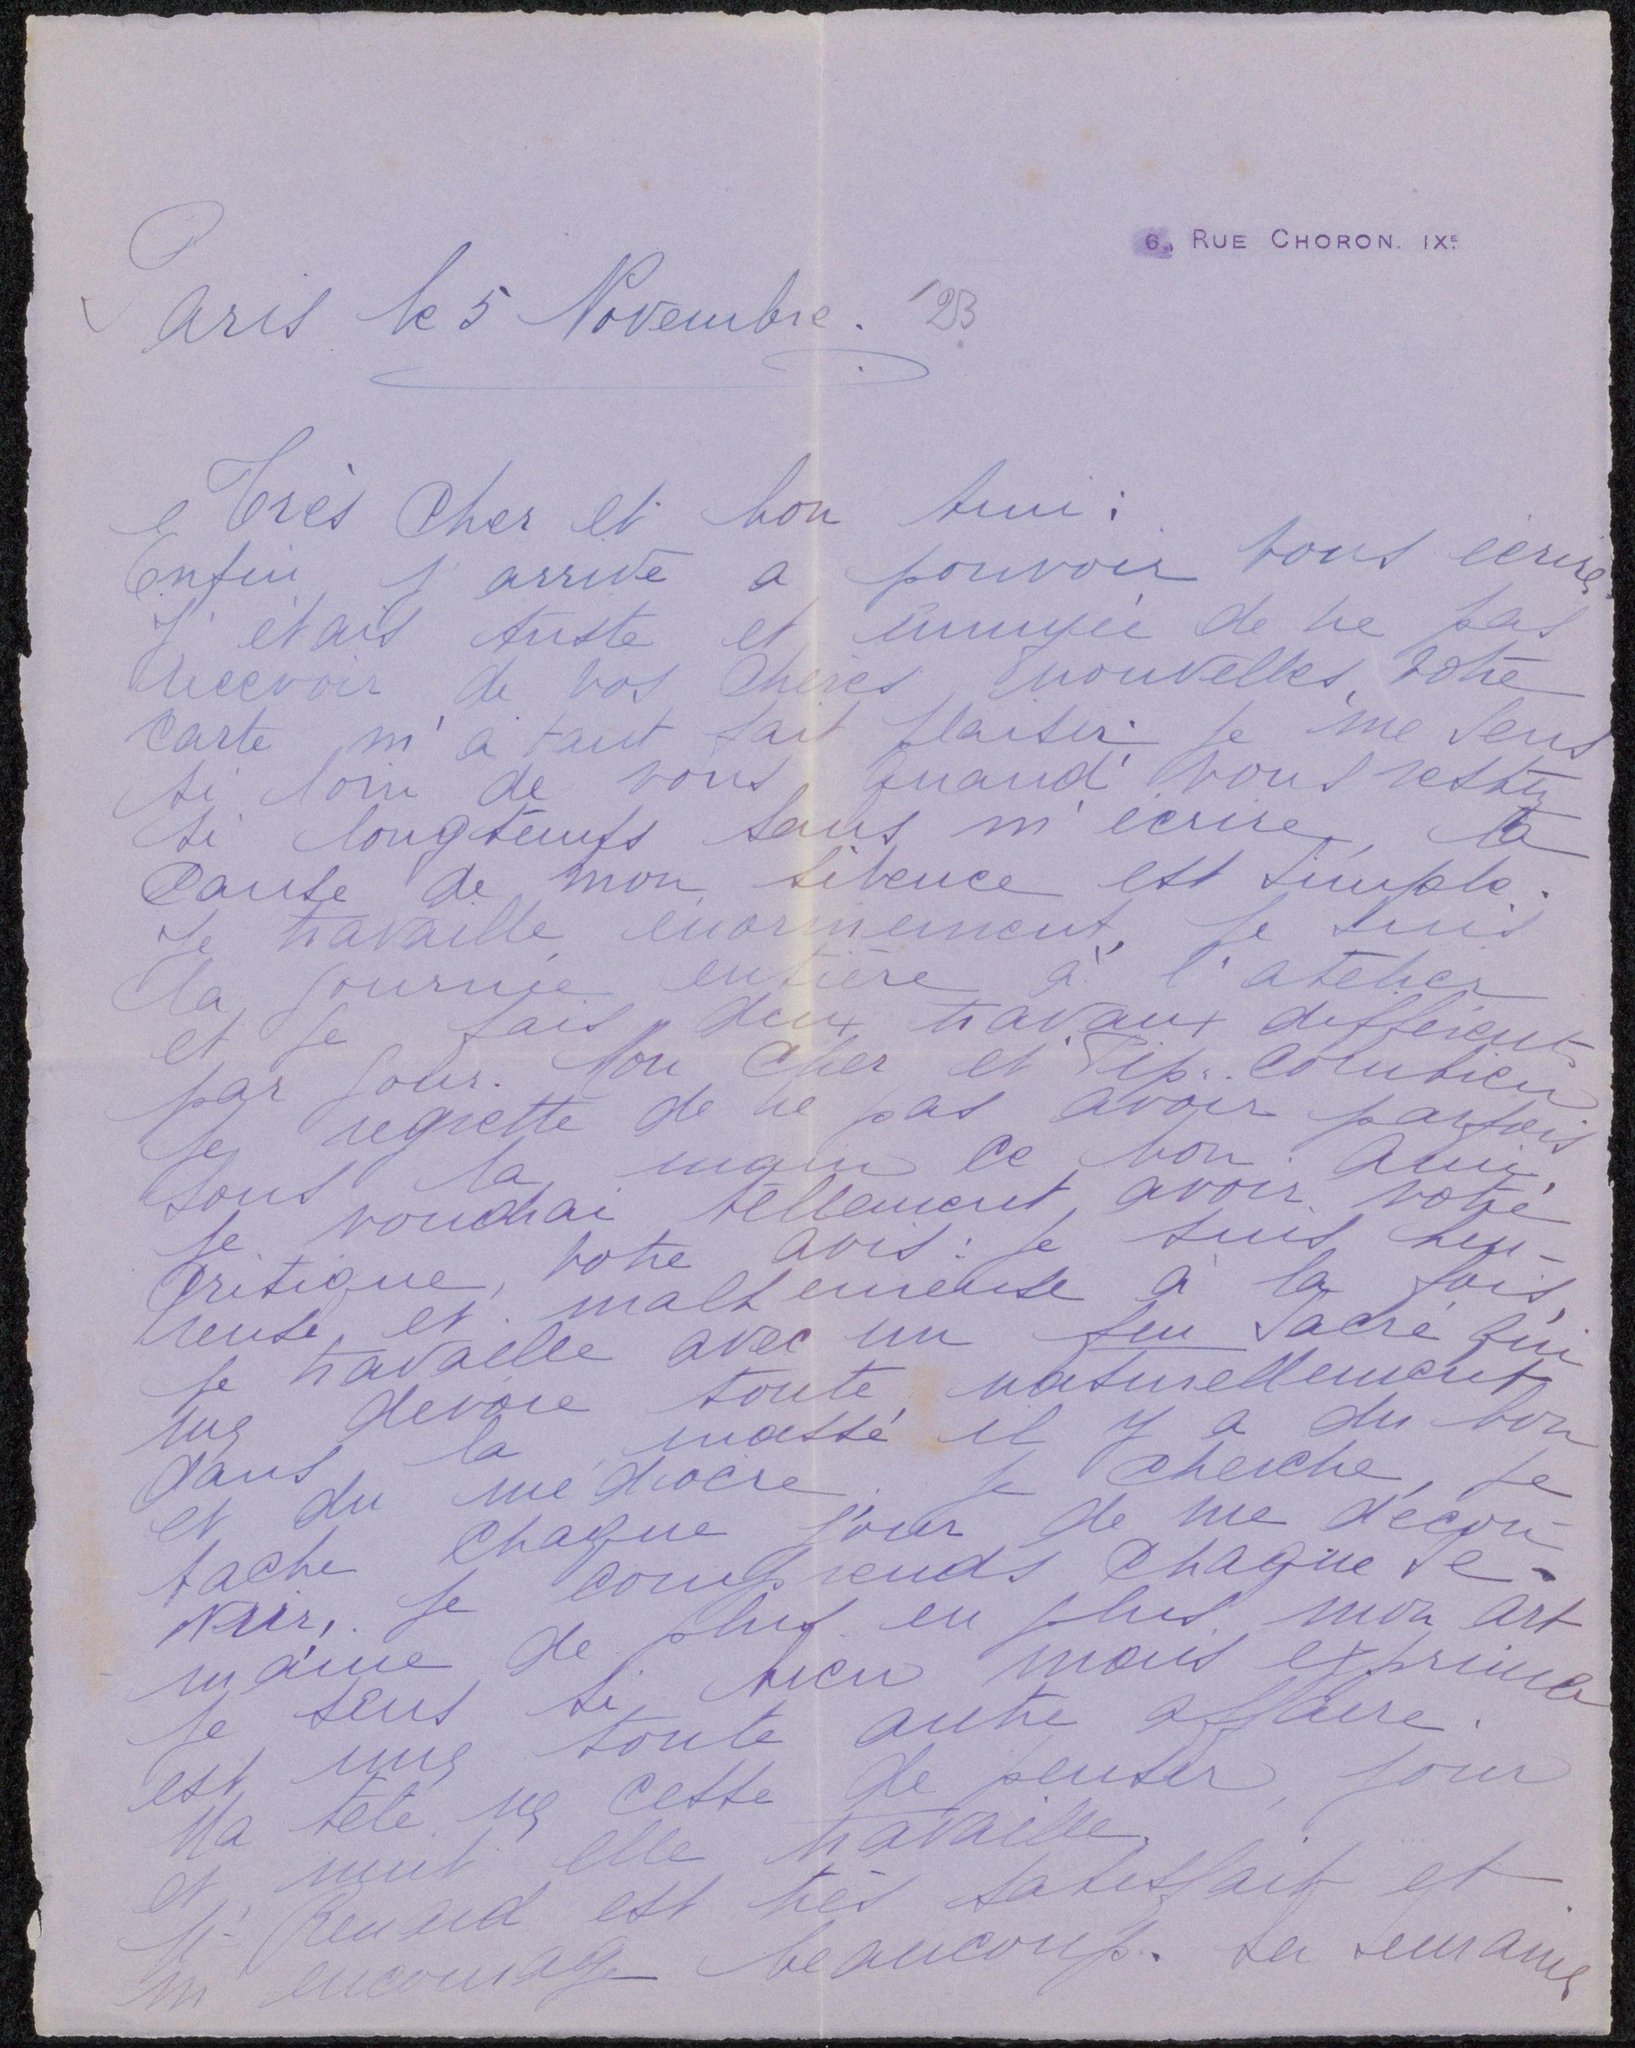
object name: letter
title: Brief aan Philip Zilcken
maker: rose imel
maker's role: draughtsman, painter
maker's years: 1901-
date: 1911-1930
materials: ink, paper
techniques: pen, printing, writing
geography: paris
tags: the hague, painter, philip zilcken, workshop, studio of the artist (in general), printed matter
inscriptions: collector's mark: ‘RPK’